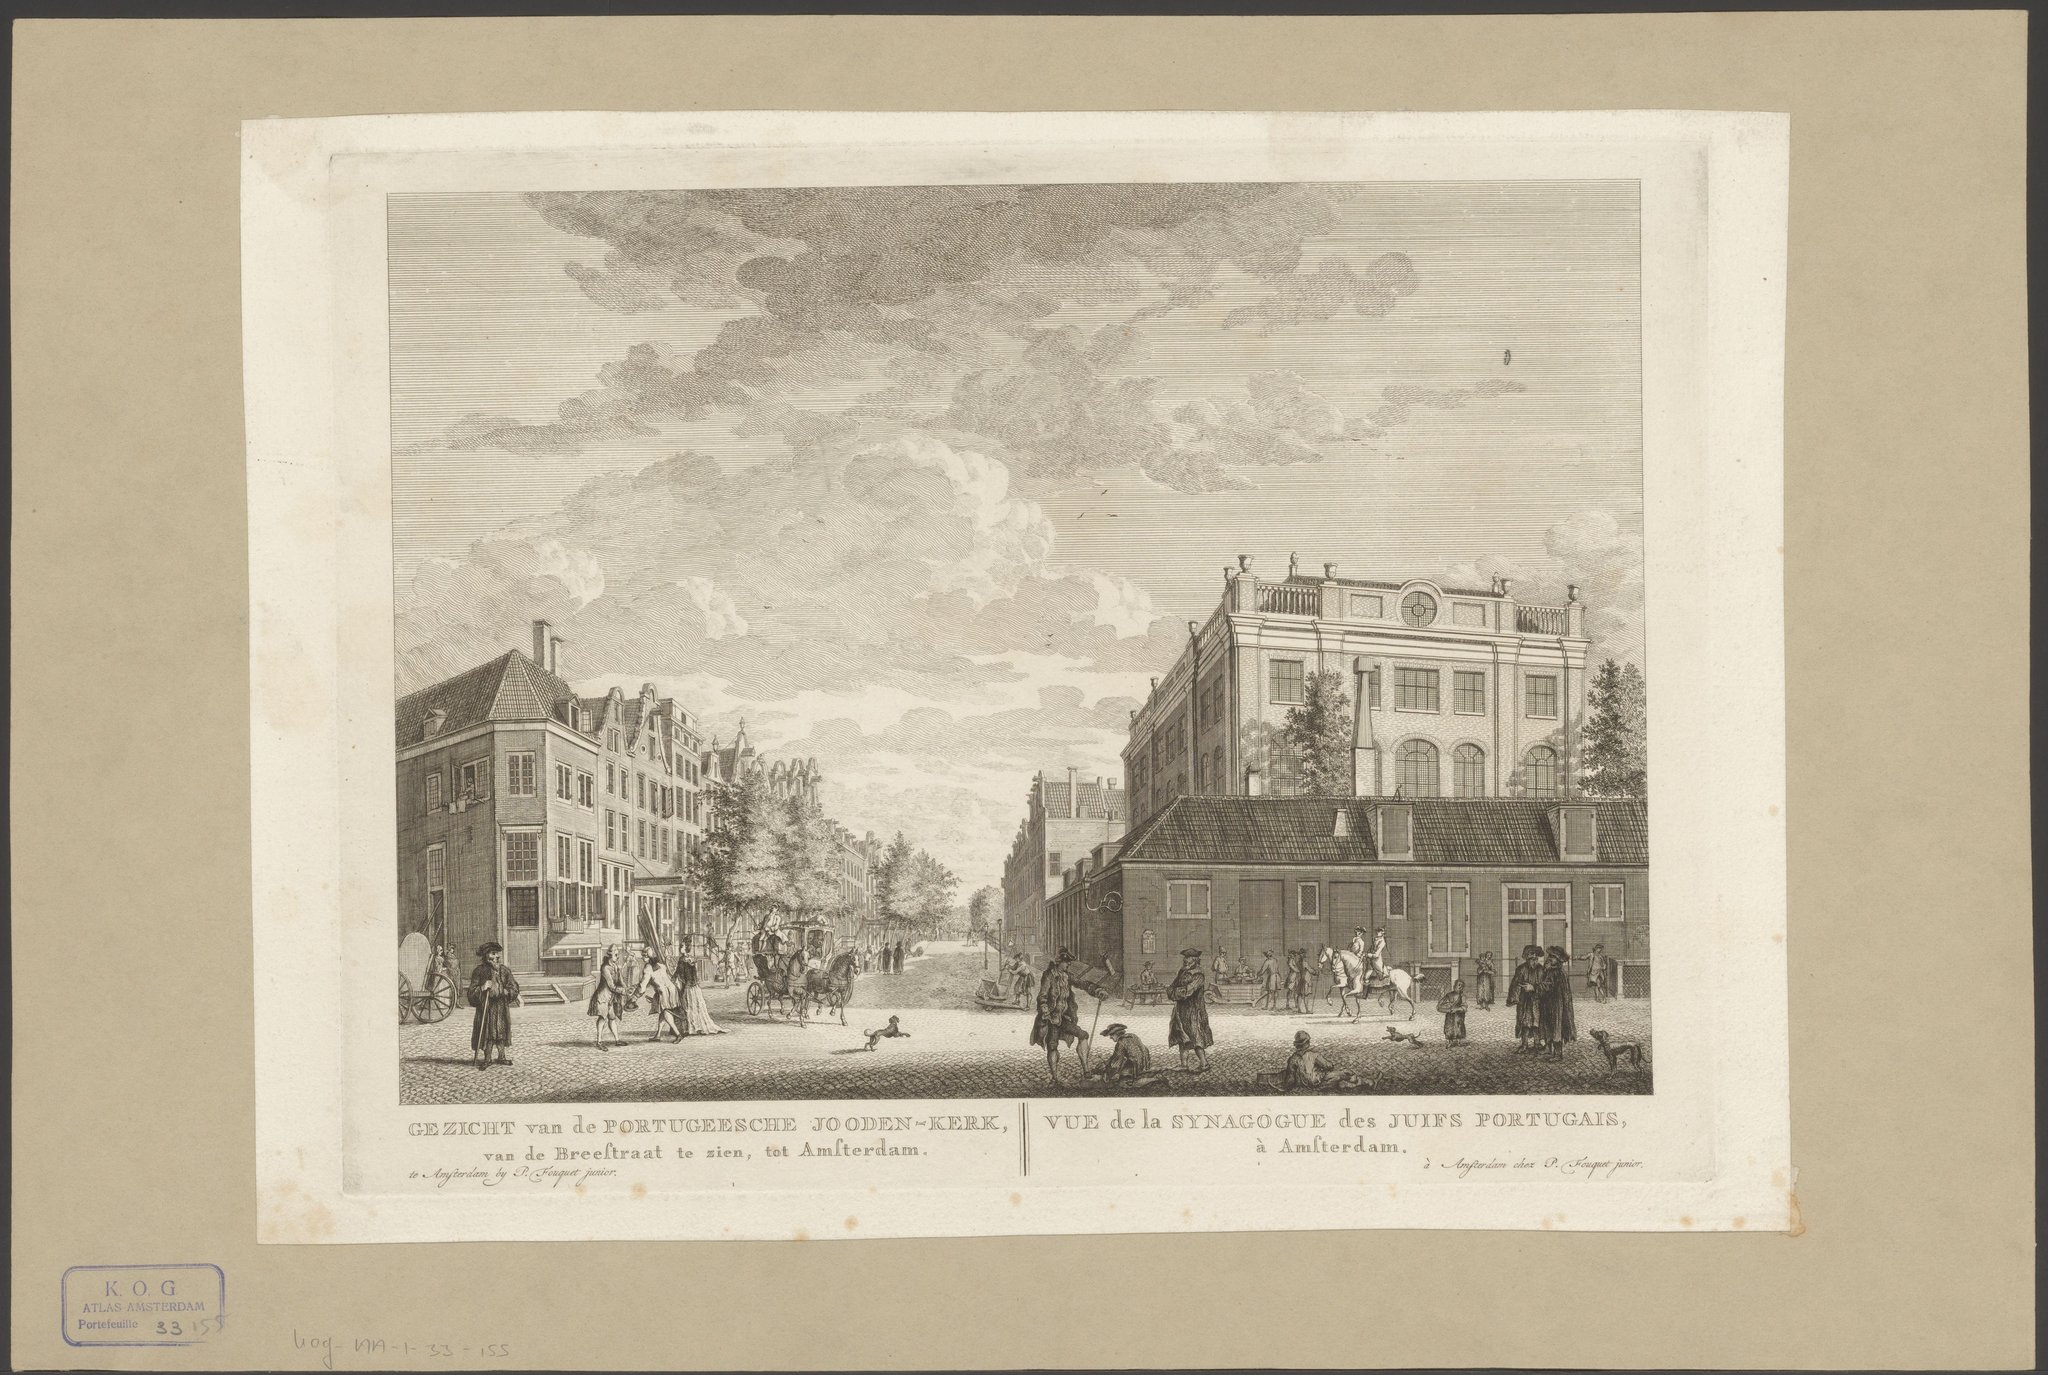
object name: print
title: Gezicht op de Portugese Synagoge te Amsterdam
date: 1768-1783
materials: paper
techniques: engraving, etching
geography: amsterdam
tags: the synagogue (as building and place of worship ~ jewish religion), street (+ city(-scape) with figures, staffage)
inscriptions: collector's mark: Lugt 1641b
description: Vanaf 1760 gaf Pierre Fouquet stadsgezichten van Amsterdam naar tekeningen van verschillende kunstenaars uit. Deze prenten werden aanvankelijk los verkocht. Later werden ze samengebonden verkocht in verschillende volgordes en aantallen in: (1). Afbeeldingen van de wyd-vermaarde koopstad Amsterdam benevens des zelvs voornaamste gebouwen en gezigten alle naar het leeven getekend / Receuil des edifices les plus considerables et des plus belles vues, de la fameuse ville d'Amsterdam, dessinées d'après nature. Amsterdam: Pierre Fouquet, 1778-1783. Deze 'uitgave' bestond waarschijnlijk alleen uit een titelblad en inhoudsopgave van de tot dusver 100 uitgegeven prenten, die de koper zelf aan zijn of haar reeds verzamelde prenten kon toevoegen. De hoeveelheid en volgorde van prenten verzameld onder deze titel verschilt dus sterk. (2). Nieuwe atlas, van de voornaamste gebouwen en gezigten der stad Amsterdam, met derzelver beknopte beschryvingen. 2 dln. Amsterdam: Daniël Jean Changuion en Petrus den Hengst [in opdracht van Pierre Fouquet], 1783. Ook werden er door verschillende uitgevers tussen 1788 (Amsterdam: Petrus Conradi) en 1805 (Amsterdam: Evert Maaskamp) heruitgaven gepubliceerd.